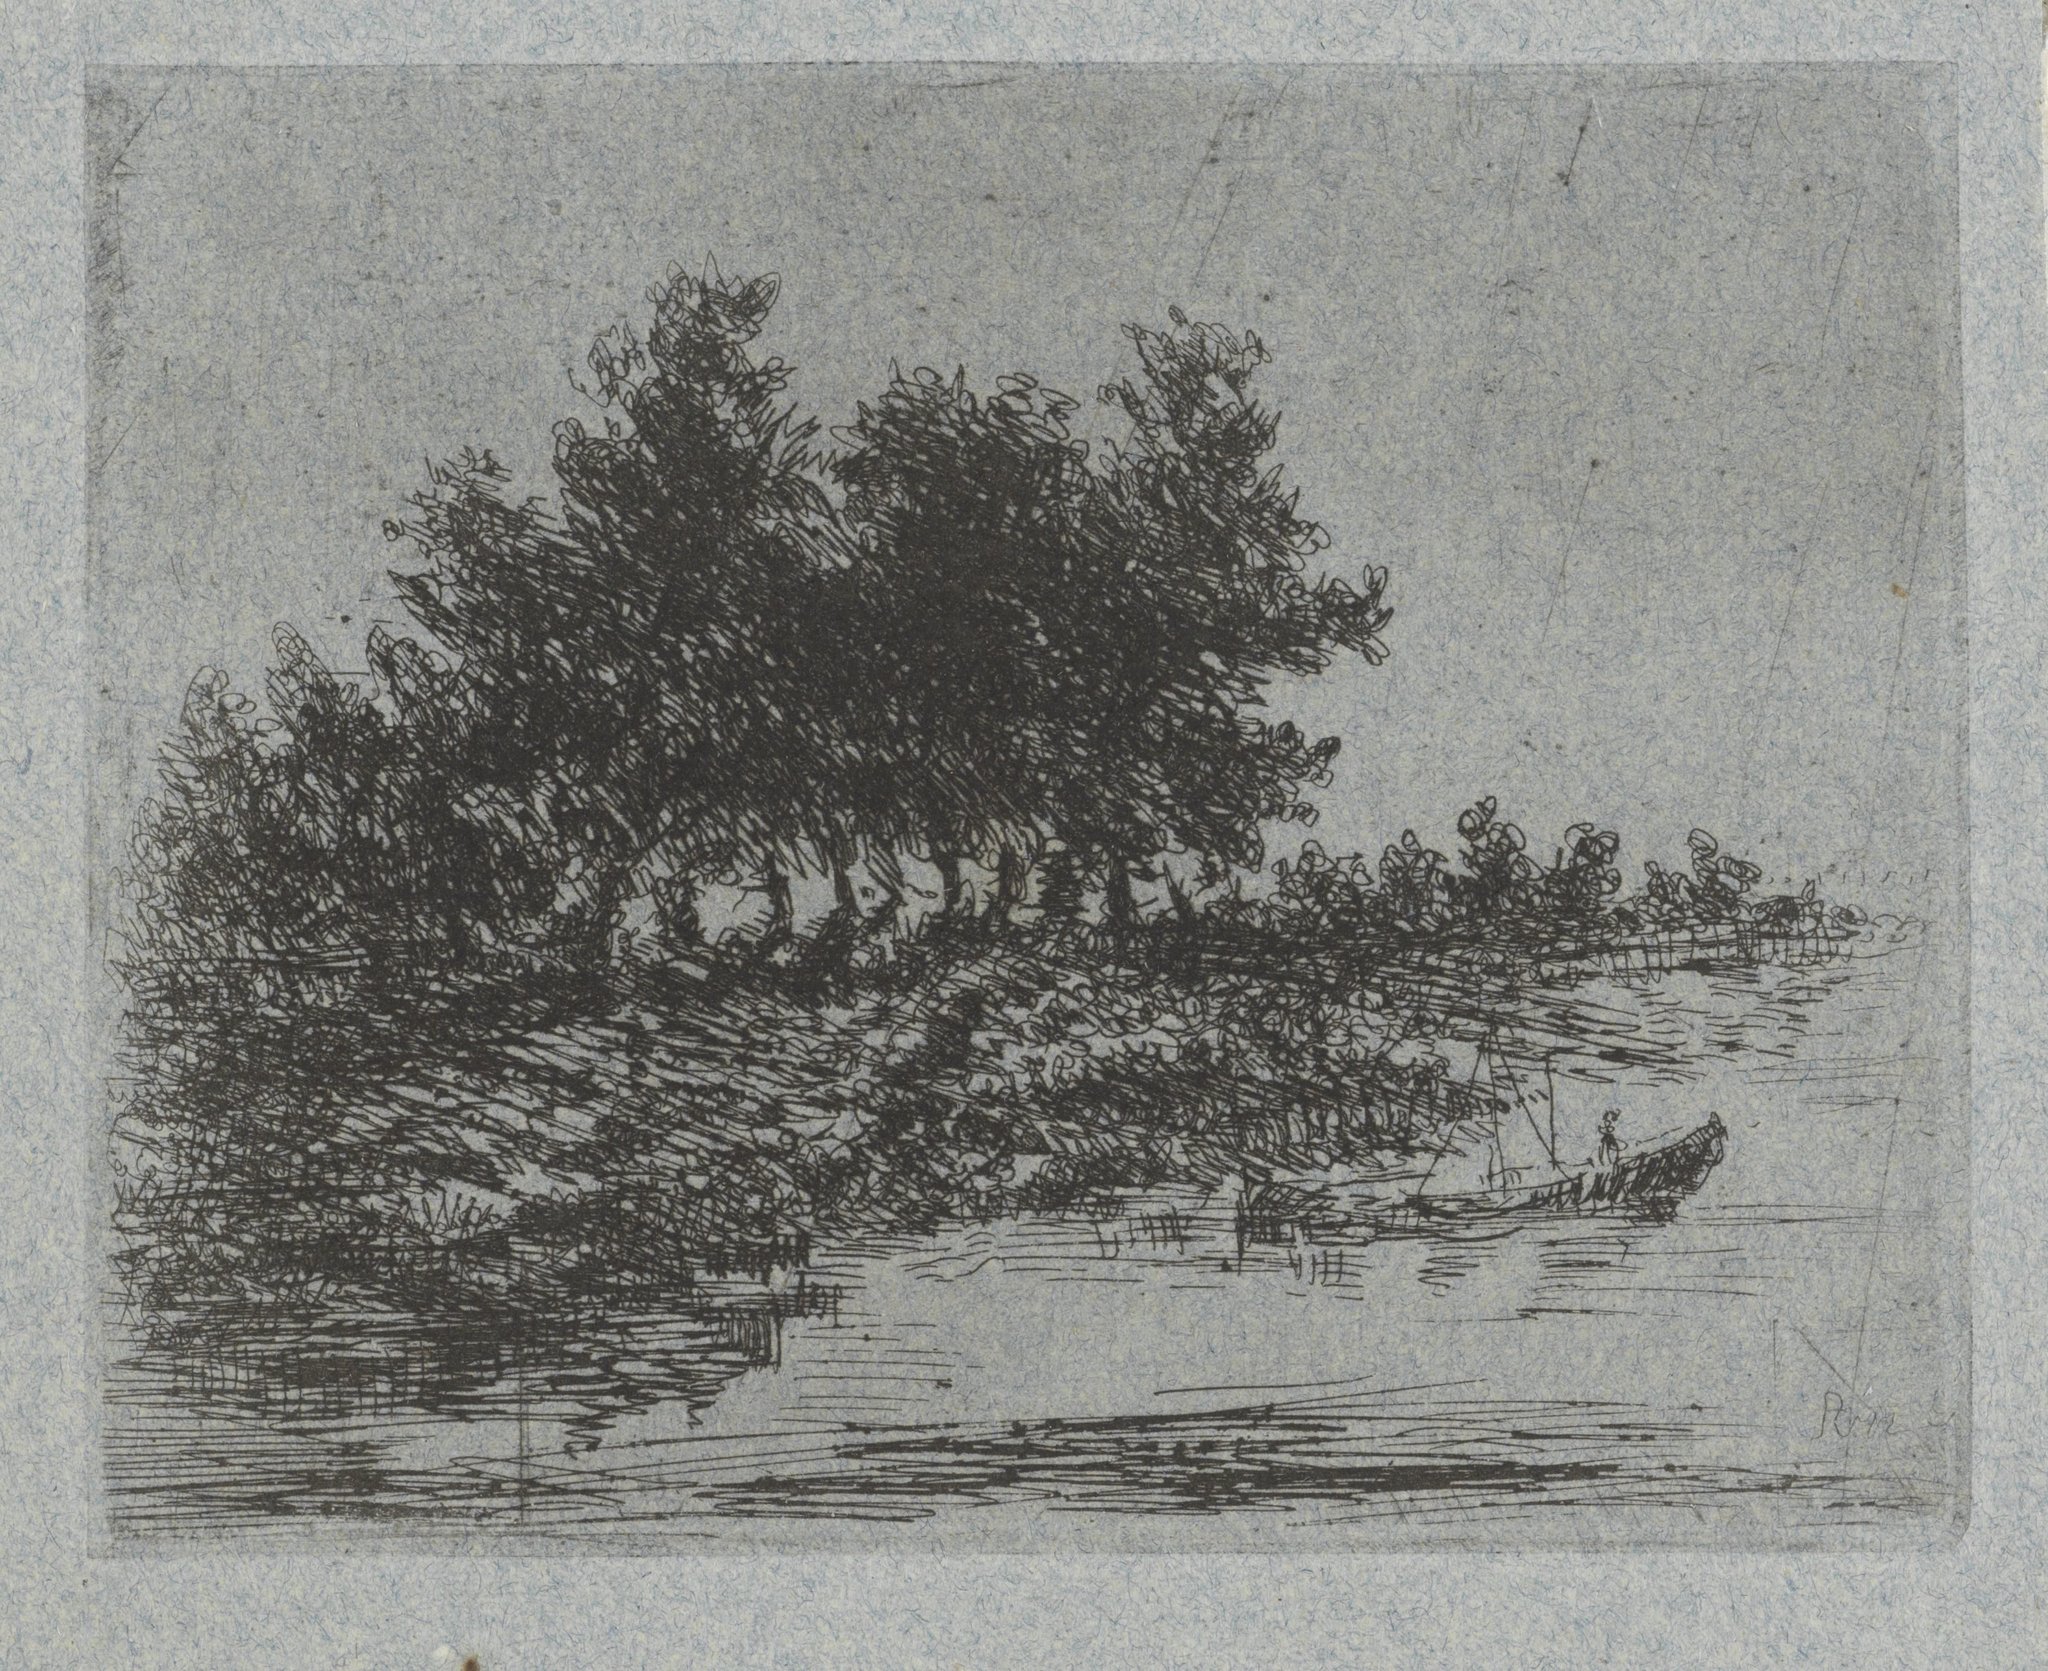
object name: print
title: Landschap met bomenrij en boot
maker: arnoud schaepkens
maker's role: print maker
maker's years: 1816-1904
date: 1831-1904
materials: paper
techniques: etching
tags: landscapes with waters, waterscapes, seascapes (in the temperate zone)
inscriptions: collector's mark: Lugt 2228